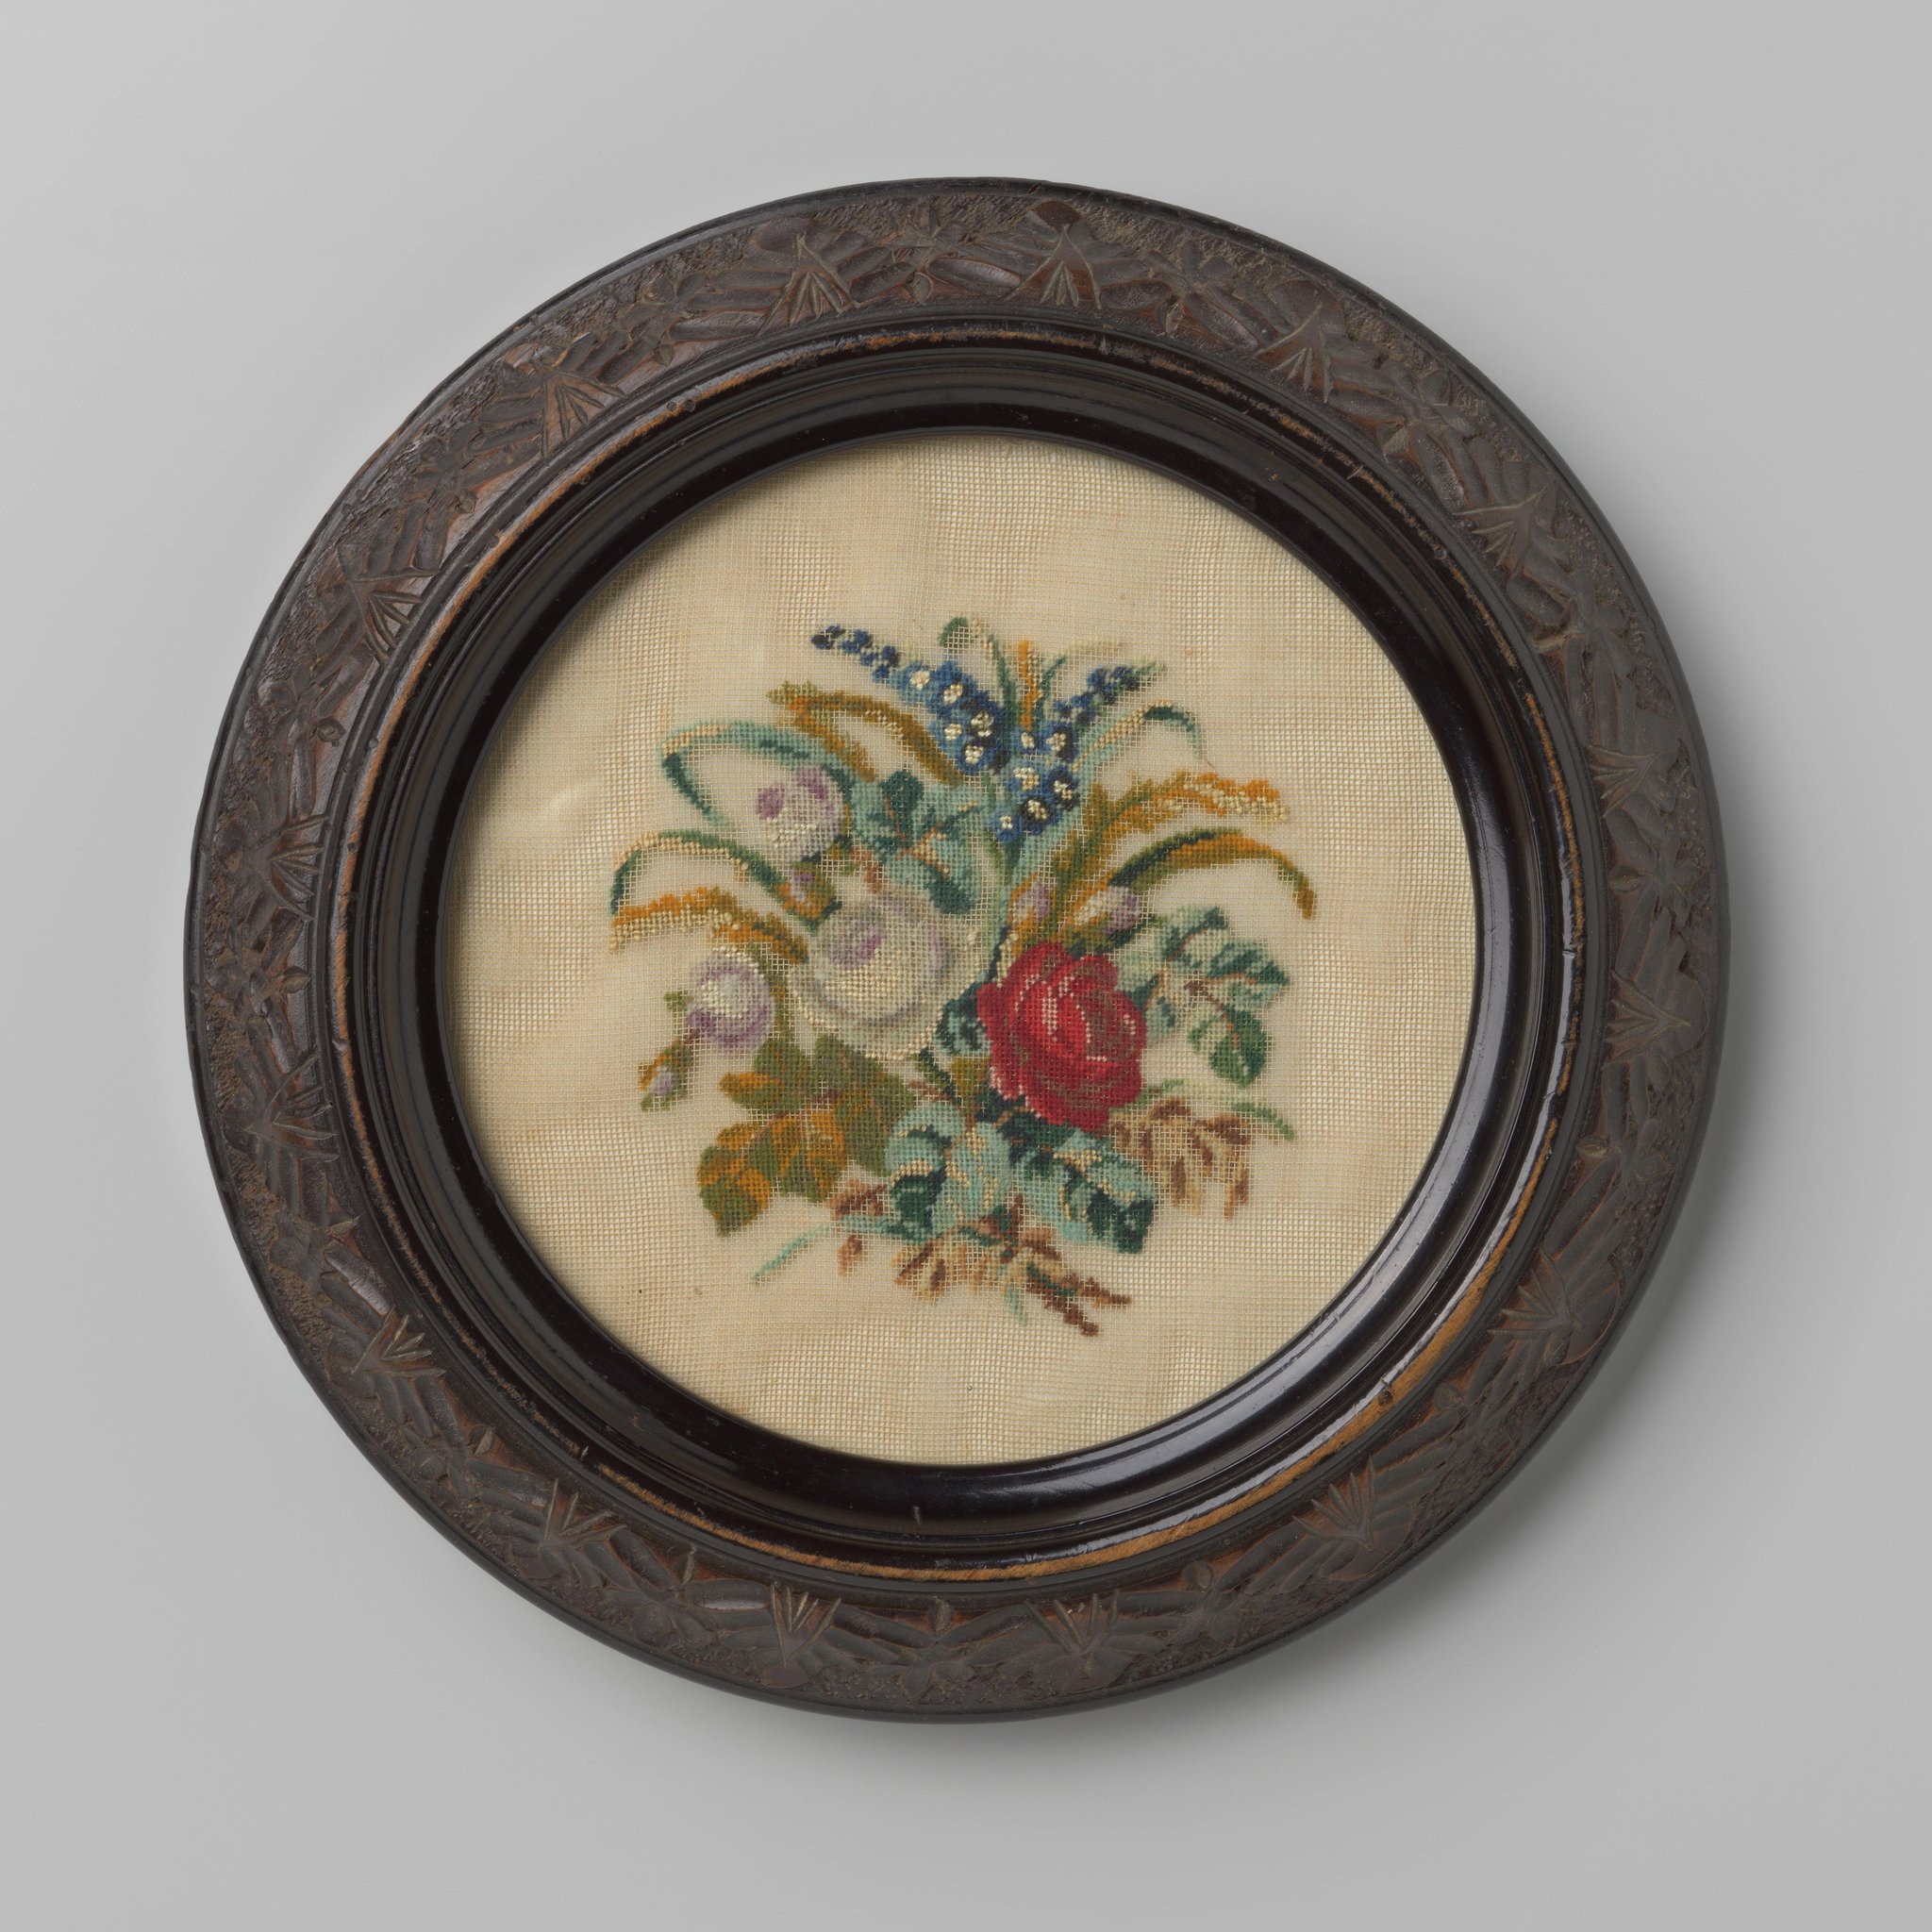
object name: tableau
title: Bloempotconsole met borduurwerk in petit-point van rozen, rozenknoppen en vergeet-mij-nietjes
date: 1870-1880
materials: cotton, linen, silk, wood, wool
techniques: embroidered, petit point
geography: netherlands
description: Bloempotconsole met borduurwerk in petit-point op stramien, in wol en hier en daar gehoogd met zijde. Patroon: een boeket van vier rozen, enige rozenknopjes en takjes vergeet-mij-nietjes op grond van onbewerkte stramien. Twee van de rozen zijn lila, de knopjes donkerrood.